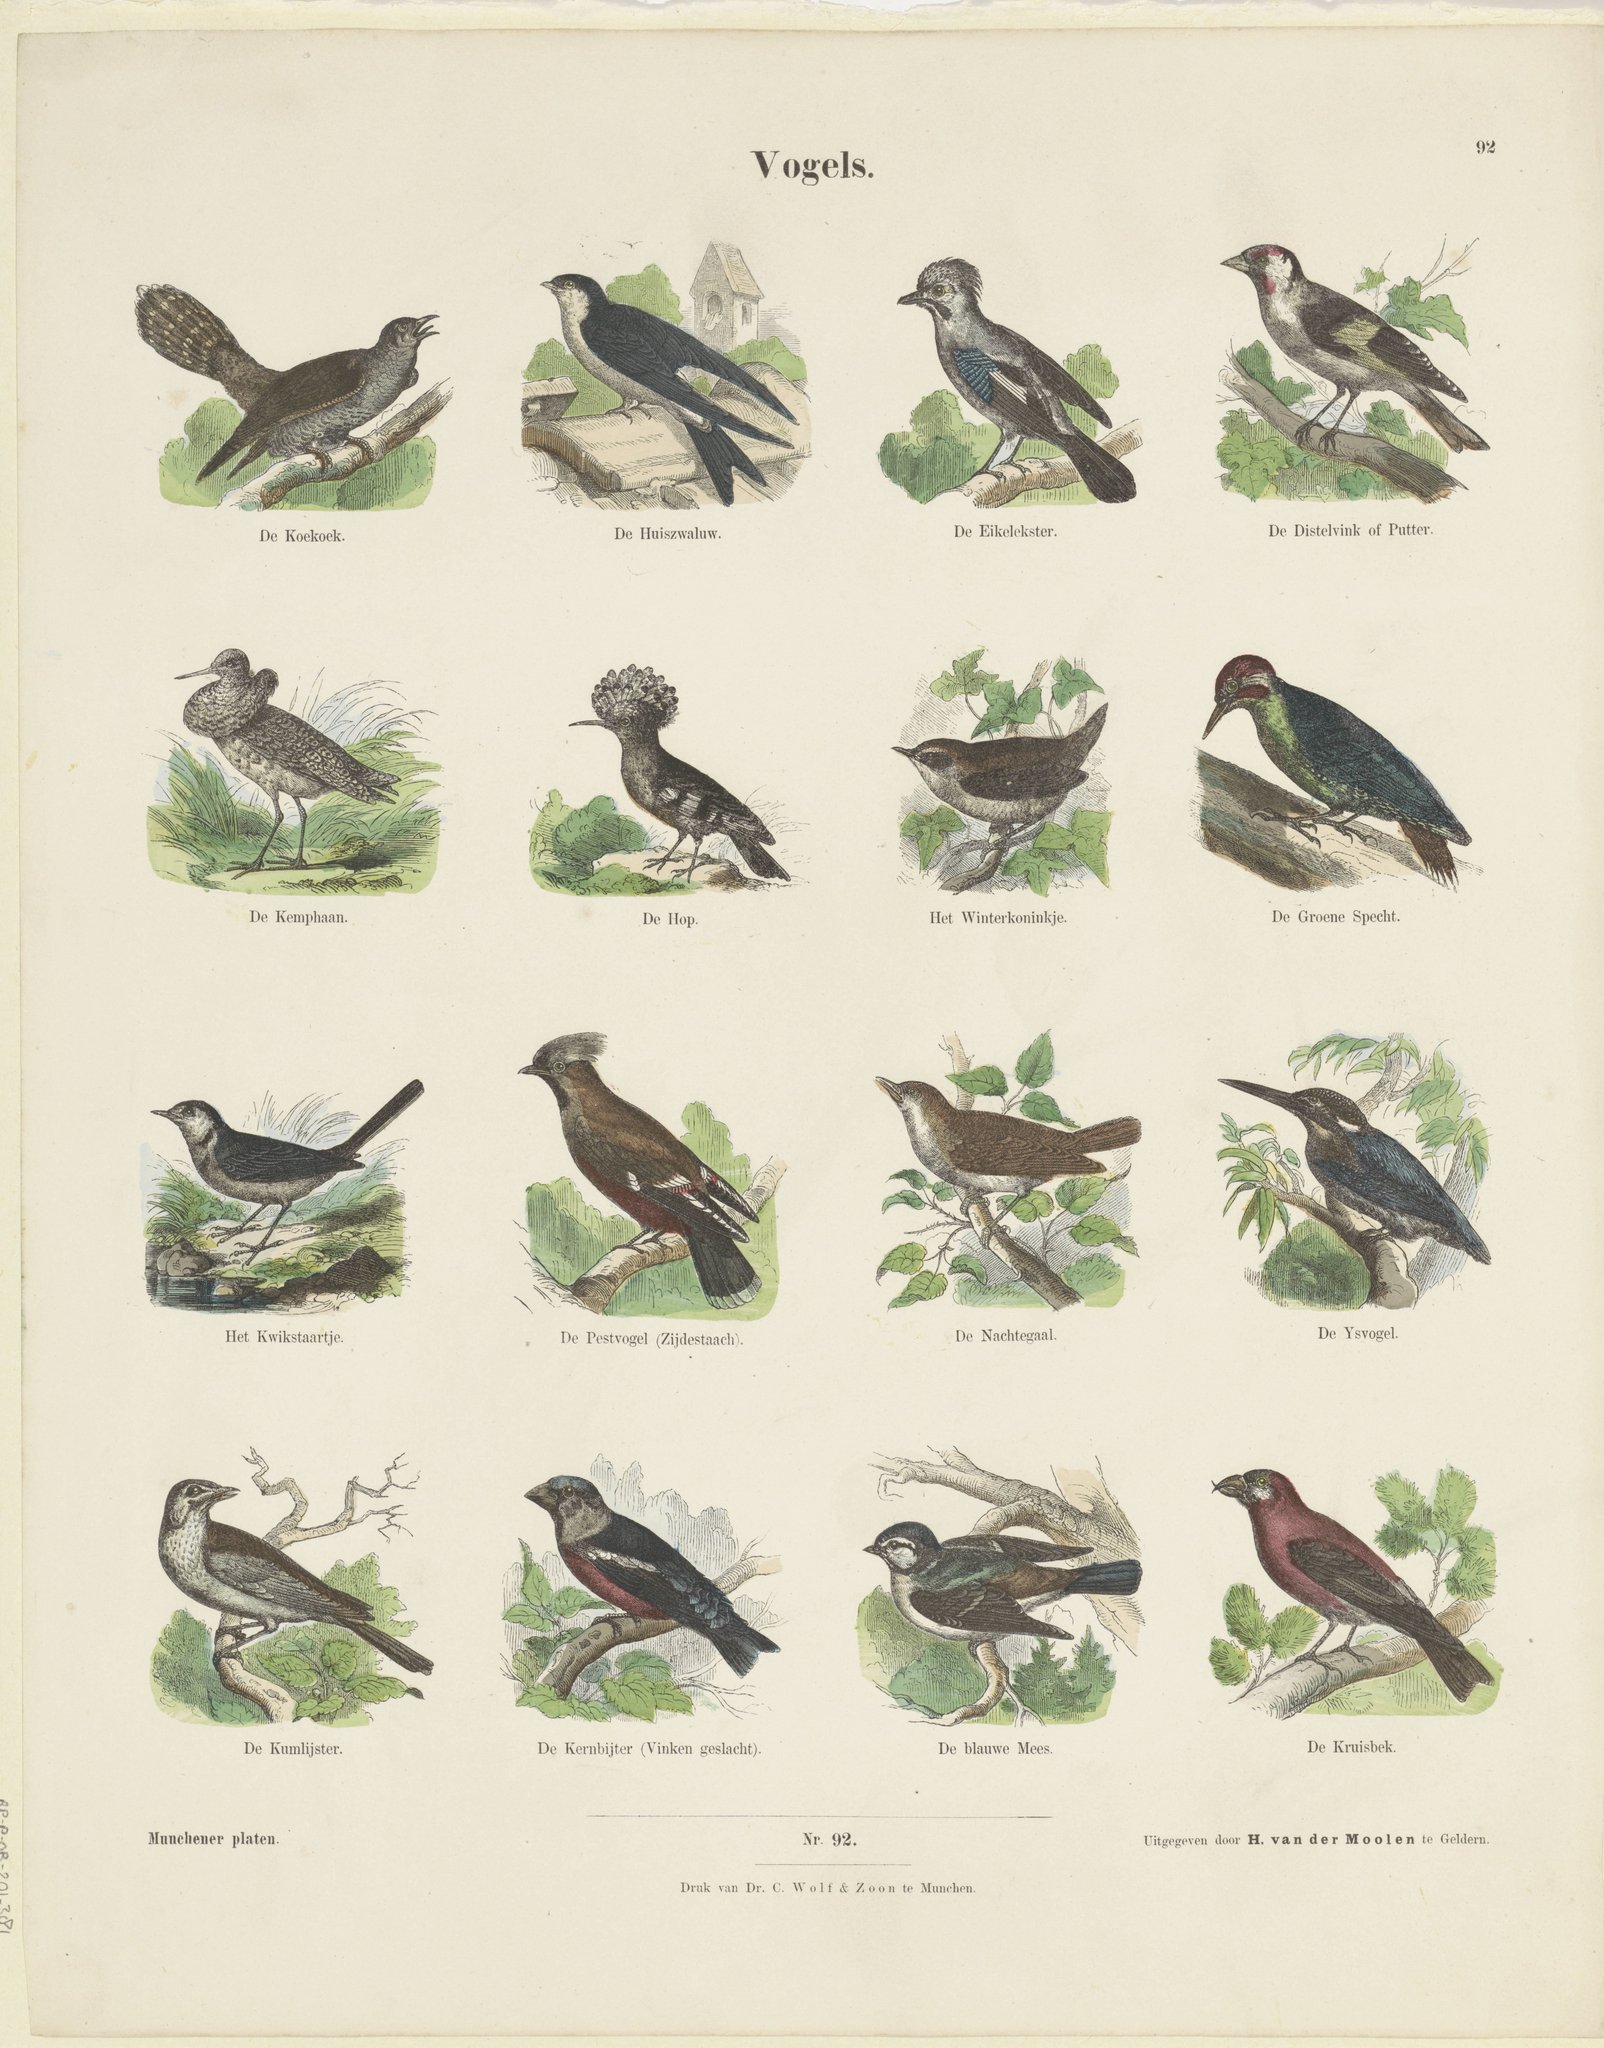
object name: print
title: Vogels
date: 1820-1843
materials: paper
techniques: colour, letterpress printing, engraving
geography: munich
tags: birds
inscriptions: collector's mark: Lugt 2760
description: Blad met 16 voorstellingen van vogels, waaronder een koekoek, een puttertje, een kemphaan, een ijsvogel, een kwikstaartje en een kruisbek. Onder de afbeeldingen een onderschrift. Genummerd midden onder: Nro. 92. Genummerd rechtsboven: 92.